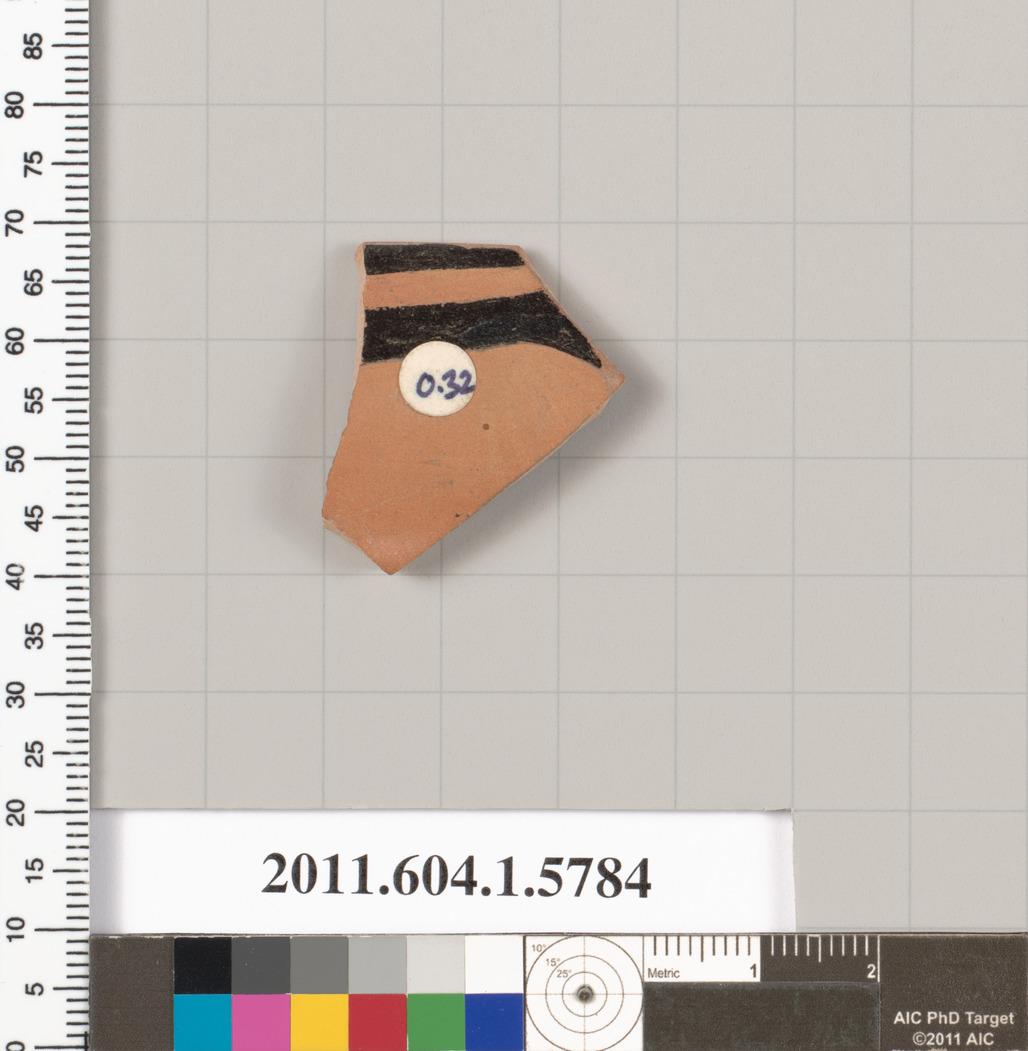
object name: kylix fragment, eye cup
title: Terracotta rim fragment of a kylix: eye-cup (drinking cup)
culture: greek, attic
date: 525-510 BCE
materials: terracotta